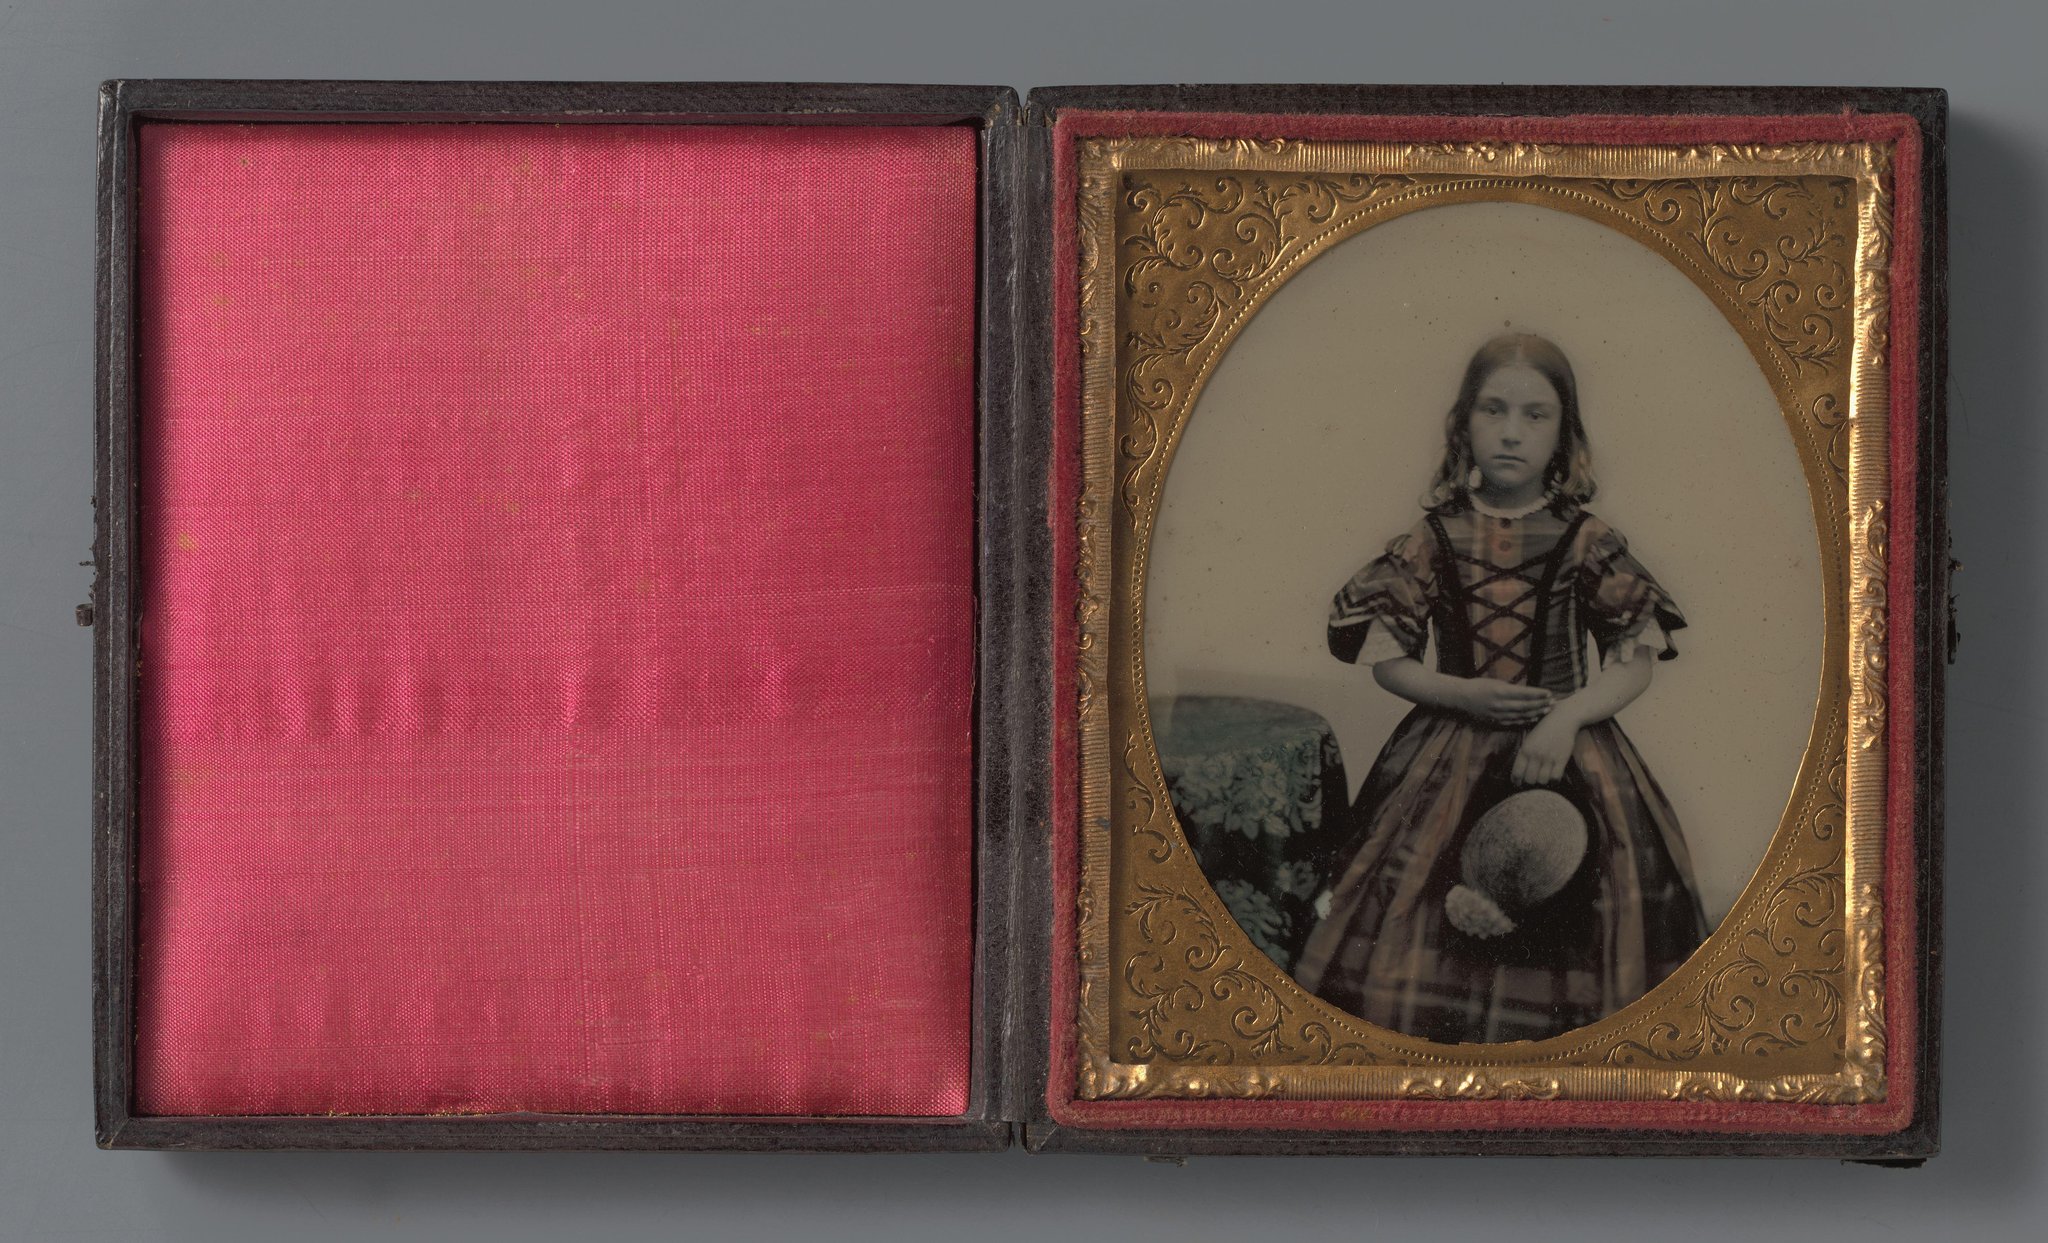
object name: photograph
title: Portret van een onbekend meisje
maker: Anonymous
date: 1855-1870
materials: glass, leather, metal, silk, velvet, wood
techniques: ambrotype, hand coloring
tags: historical persons - bb - woman, girl (child between toddler and youth), head-gear: hat